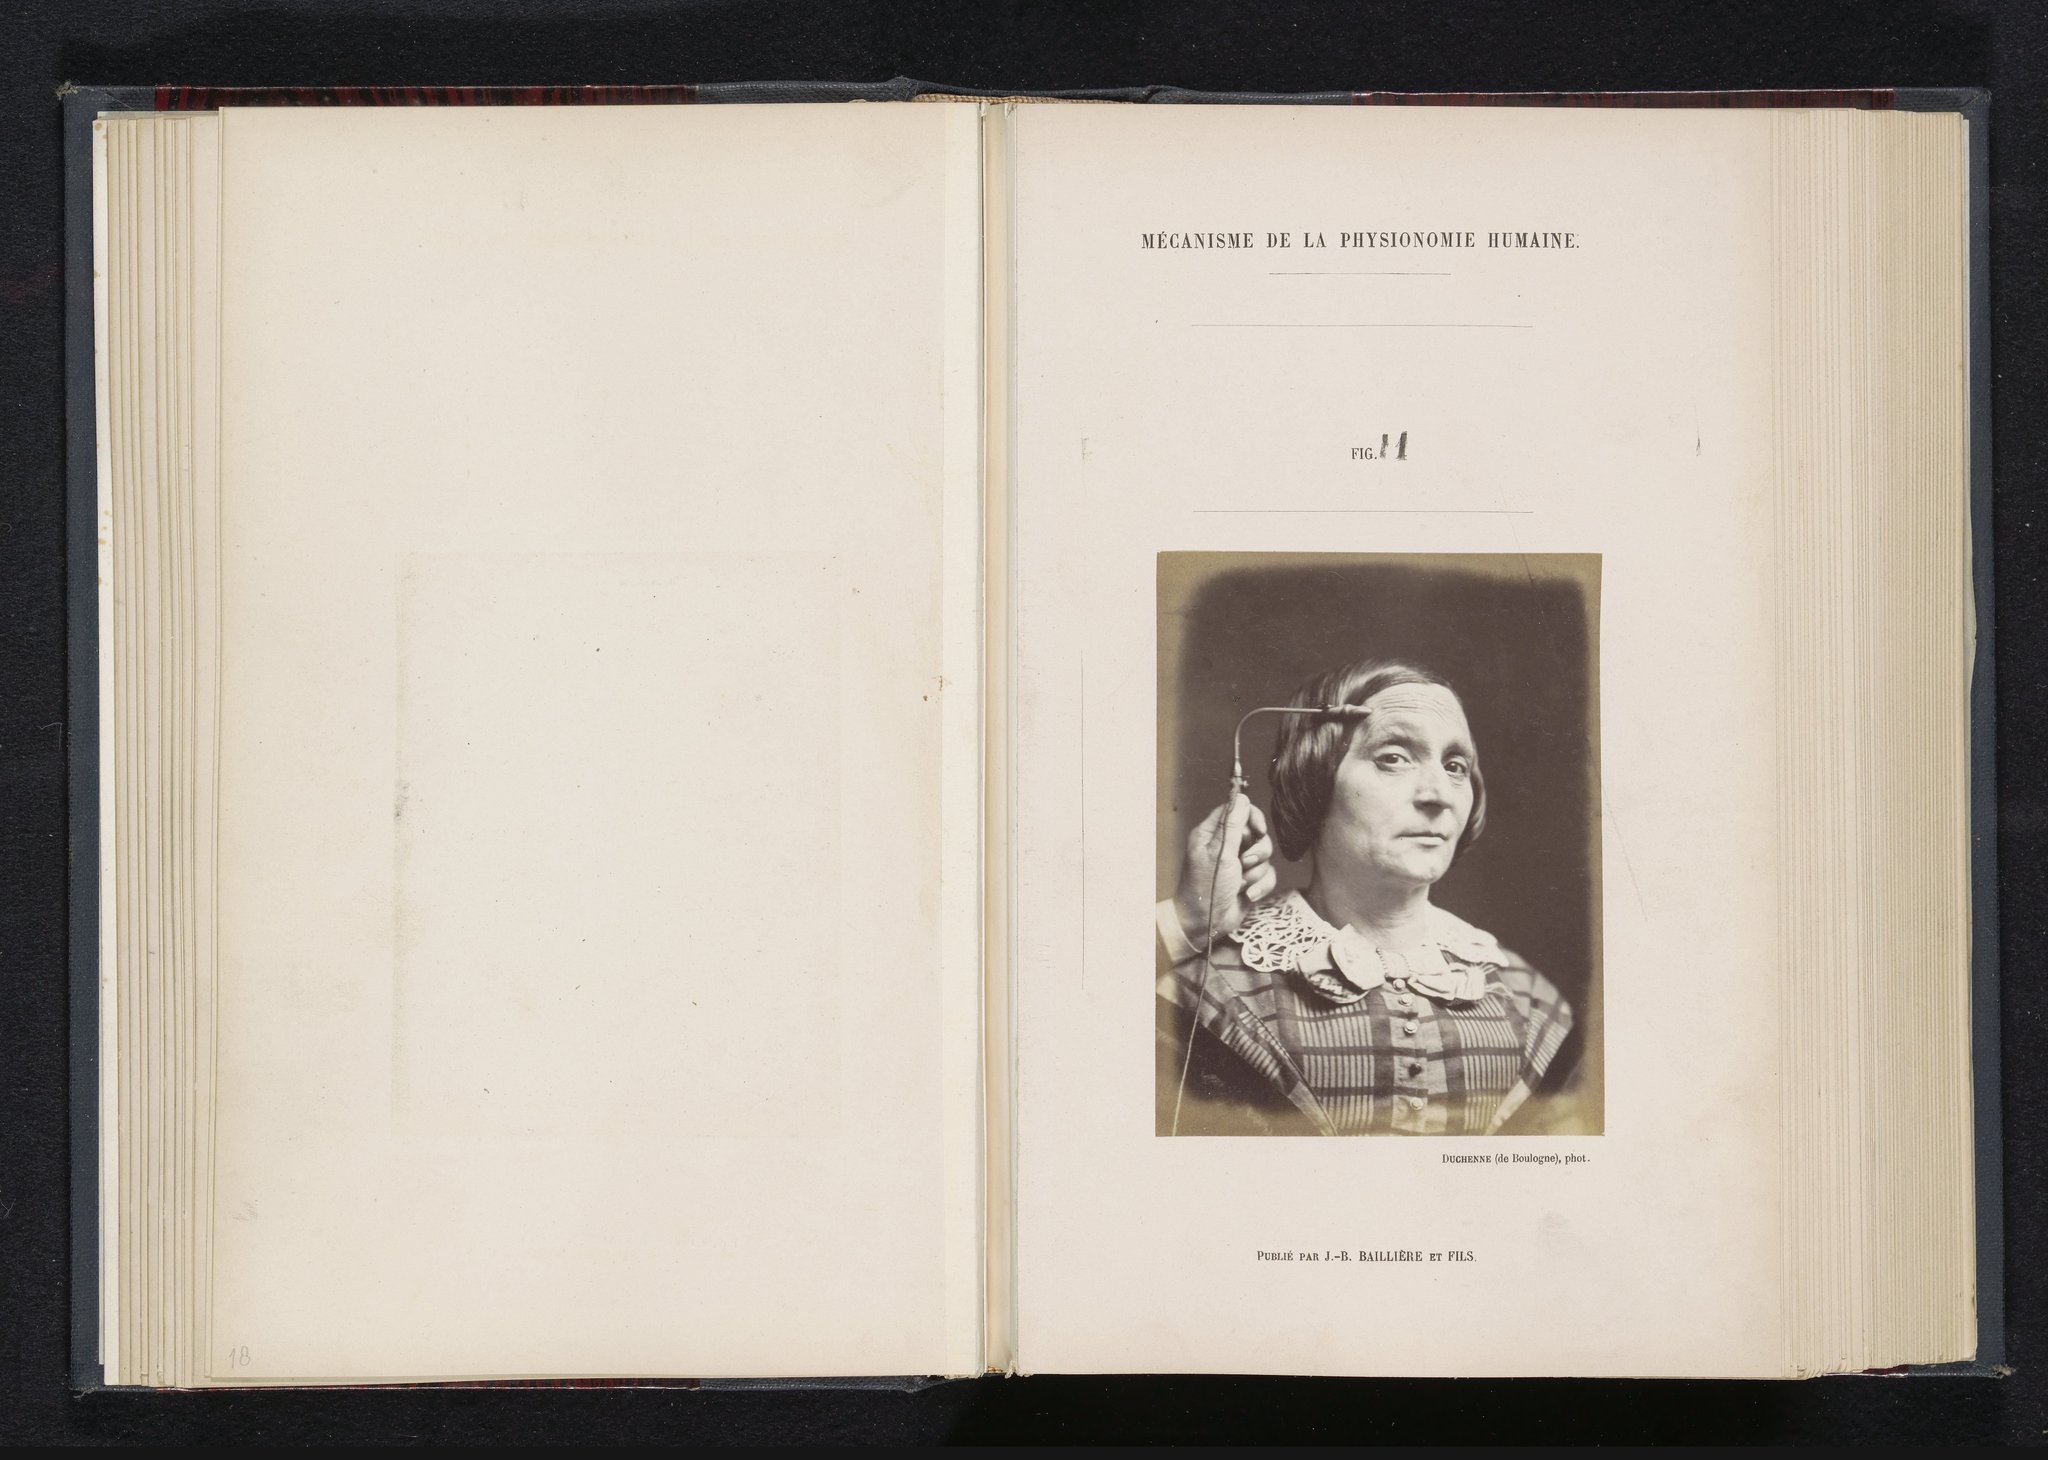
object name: page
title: Portret van een proefpersoon tijdens elektrostimulatie: 'une femme âgée de cinquante-deux'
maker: guillaume benjamin amand duchenne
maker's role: fotograaf, medicus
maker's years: 1806-1875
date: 1860-1862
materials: paper, photographic support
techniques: albumen print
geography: france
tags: face, adult woman, physiology and anatomy ~ nervous system, neurology, physiology and anatomy, morphology of facial expression, physiognomy, experiment, test ~ science and technology, france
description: Ongenummerde pagina met foto 11 uit Mécanisme de la physionomie humaine ou analyse électro-physiologique de l'expression des passions (Atlas).